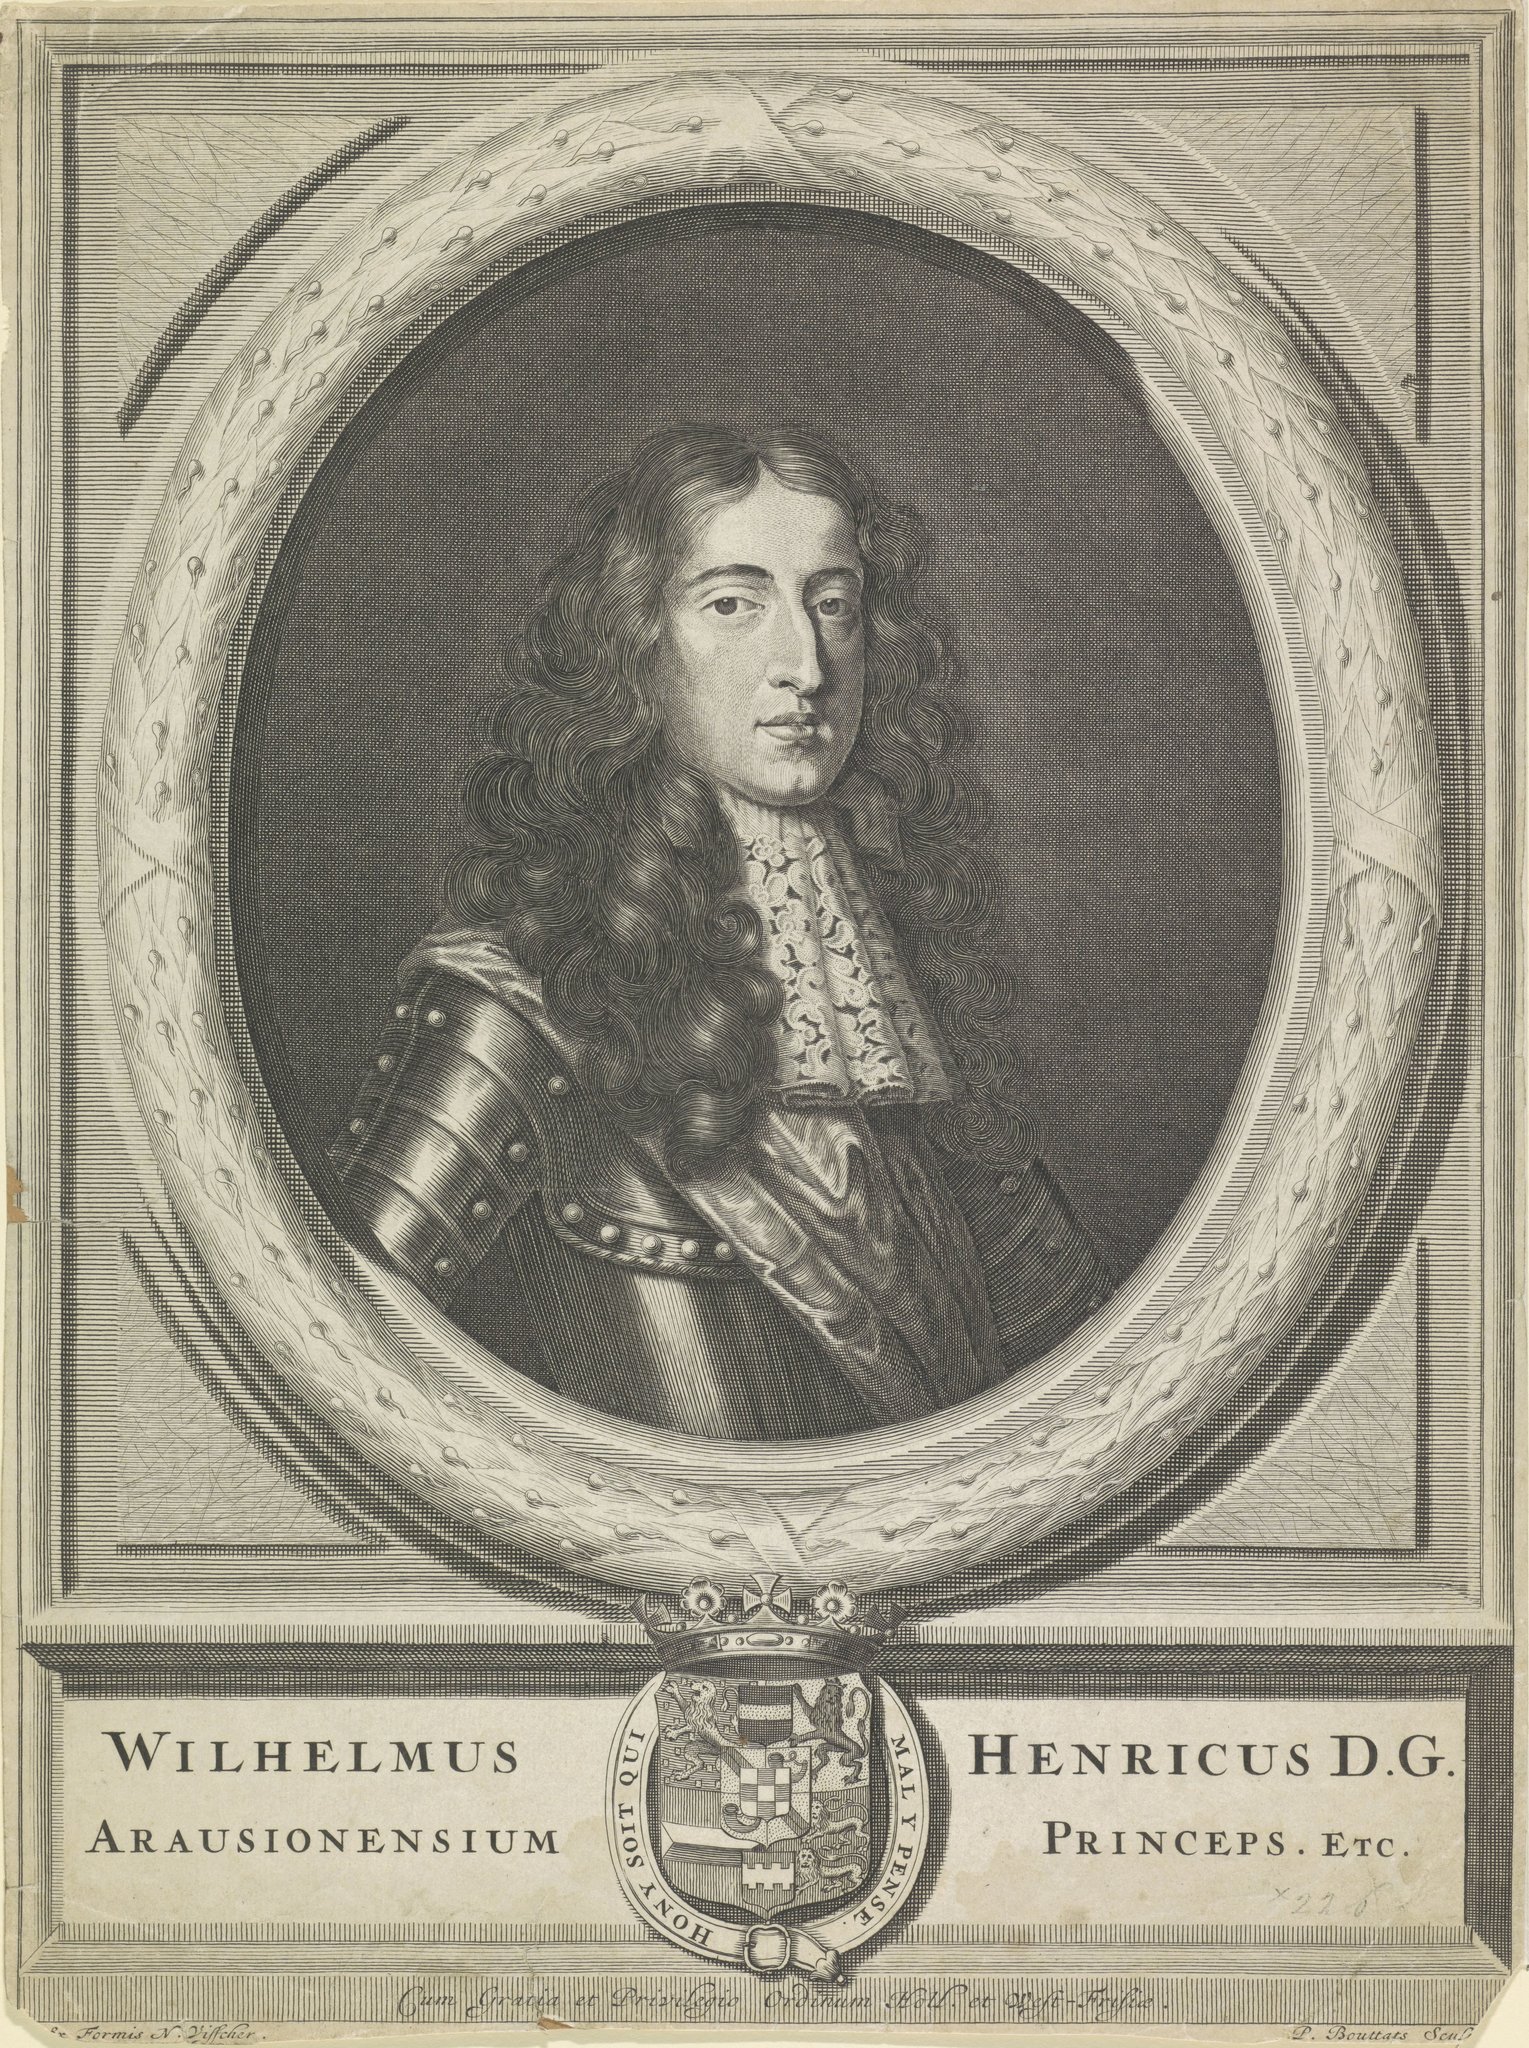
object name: print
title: Portret van Willem III, prins van Oranje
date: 1670-1709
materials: paper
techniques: engraving, etching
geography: low countries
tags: the hague, william iii (prince of orange and king of england, scotland, and ireland), knighthood order (garter) - insignia of a knighthood order, e.g.: badge, chain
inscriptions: collector's mark: Lugt 963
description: Portret van Willem III in een ovaal. Midden onder zijn wapen met een kroon, gedecoreerd met de Kousenband en het devies van de Orde van de Kousenband. In een kader zijn naam.